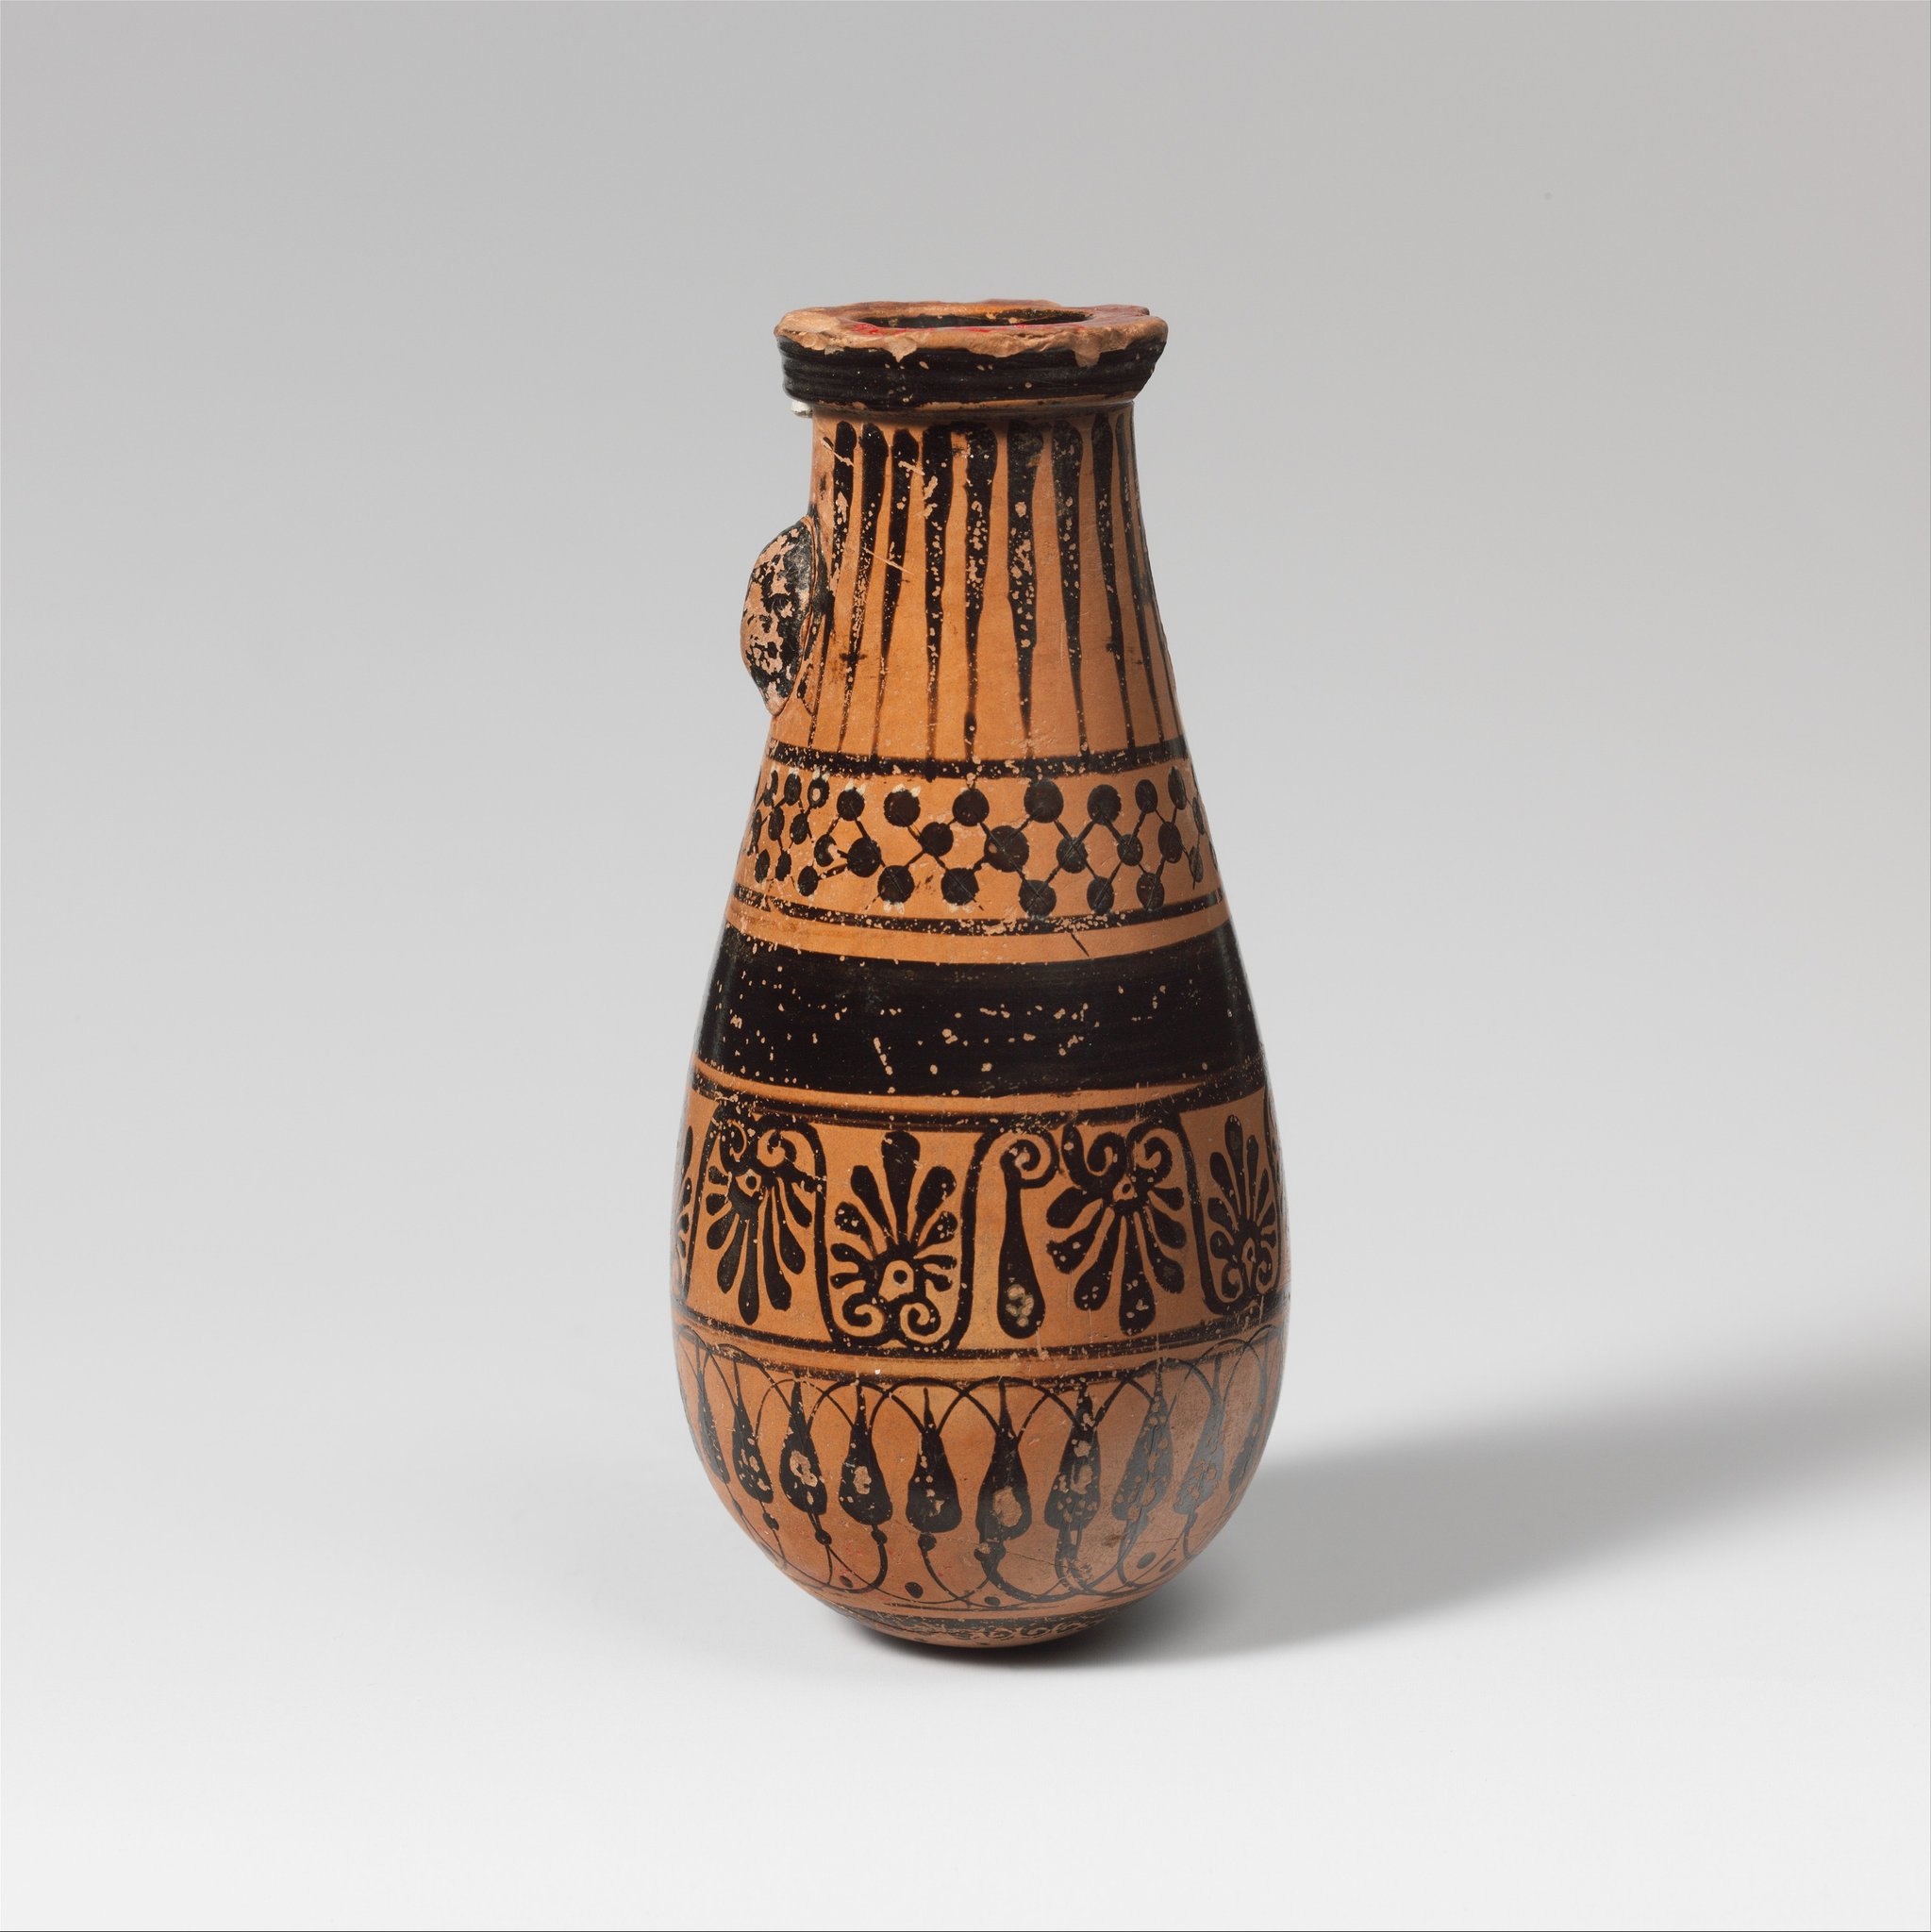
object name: alabastron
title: Terracotta alabastron (perfume vase)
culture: greek, attic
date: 520 BCE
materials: terracotta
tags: medusa